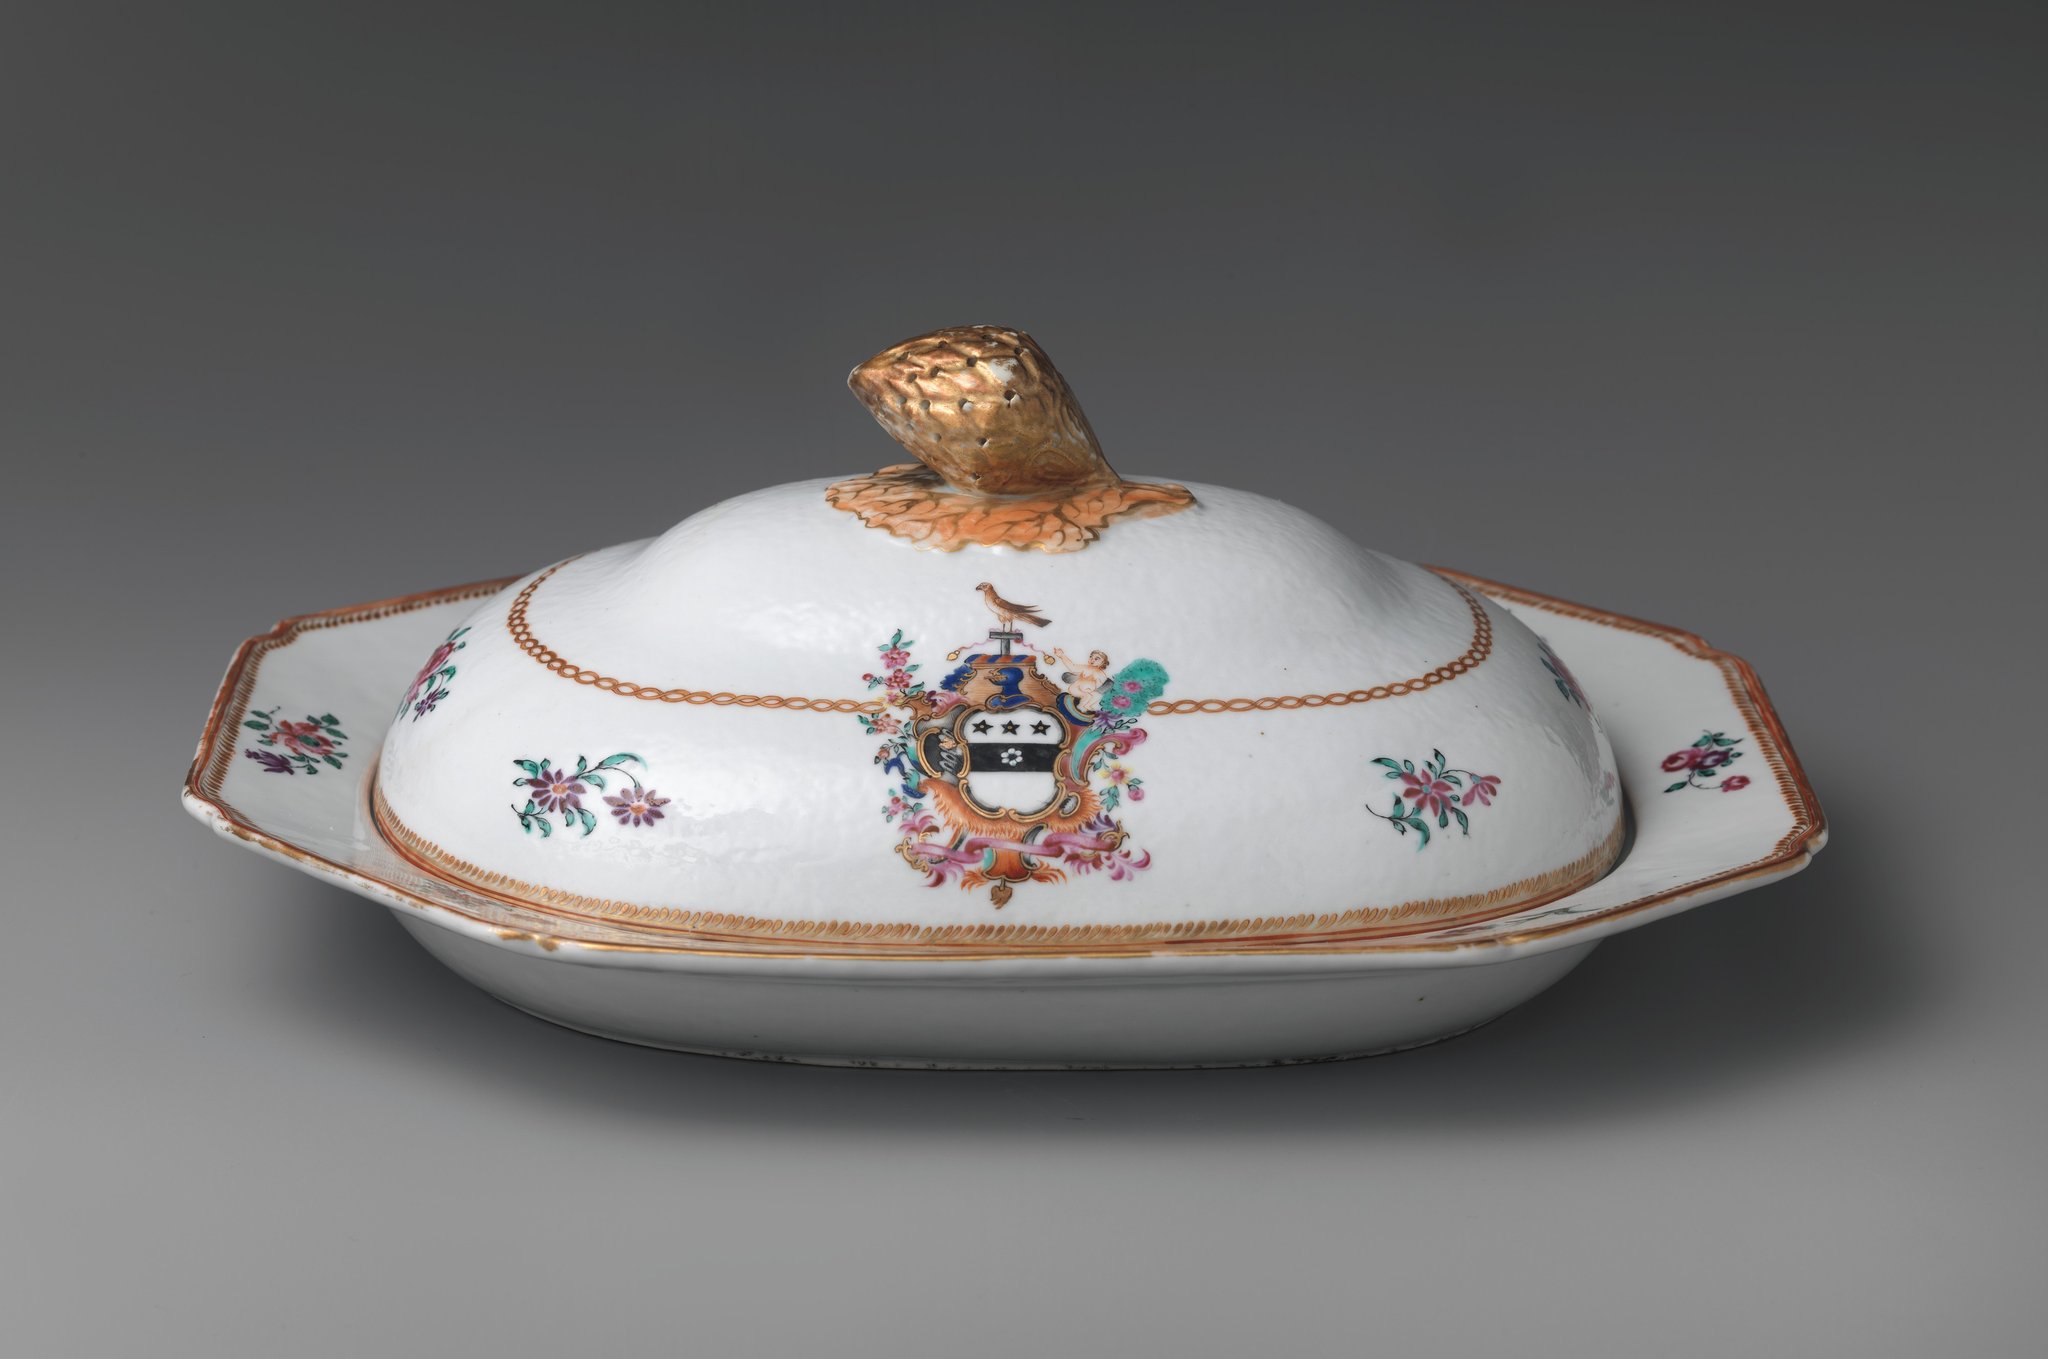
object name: platter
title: Covered Platter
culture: chinese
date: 1785-1790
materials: porcelain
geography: china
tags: birds,flowers,coat of arms